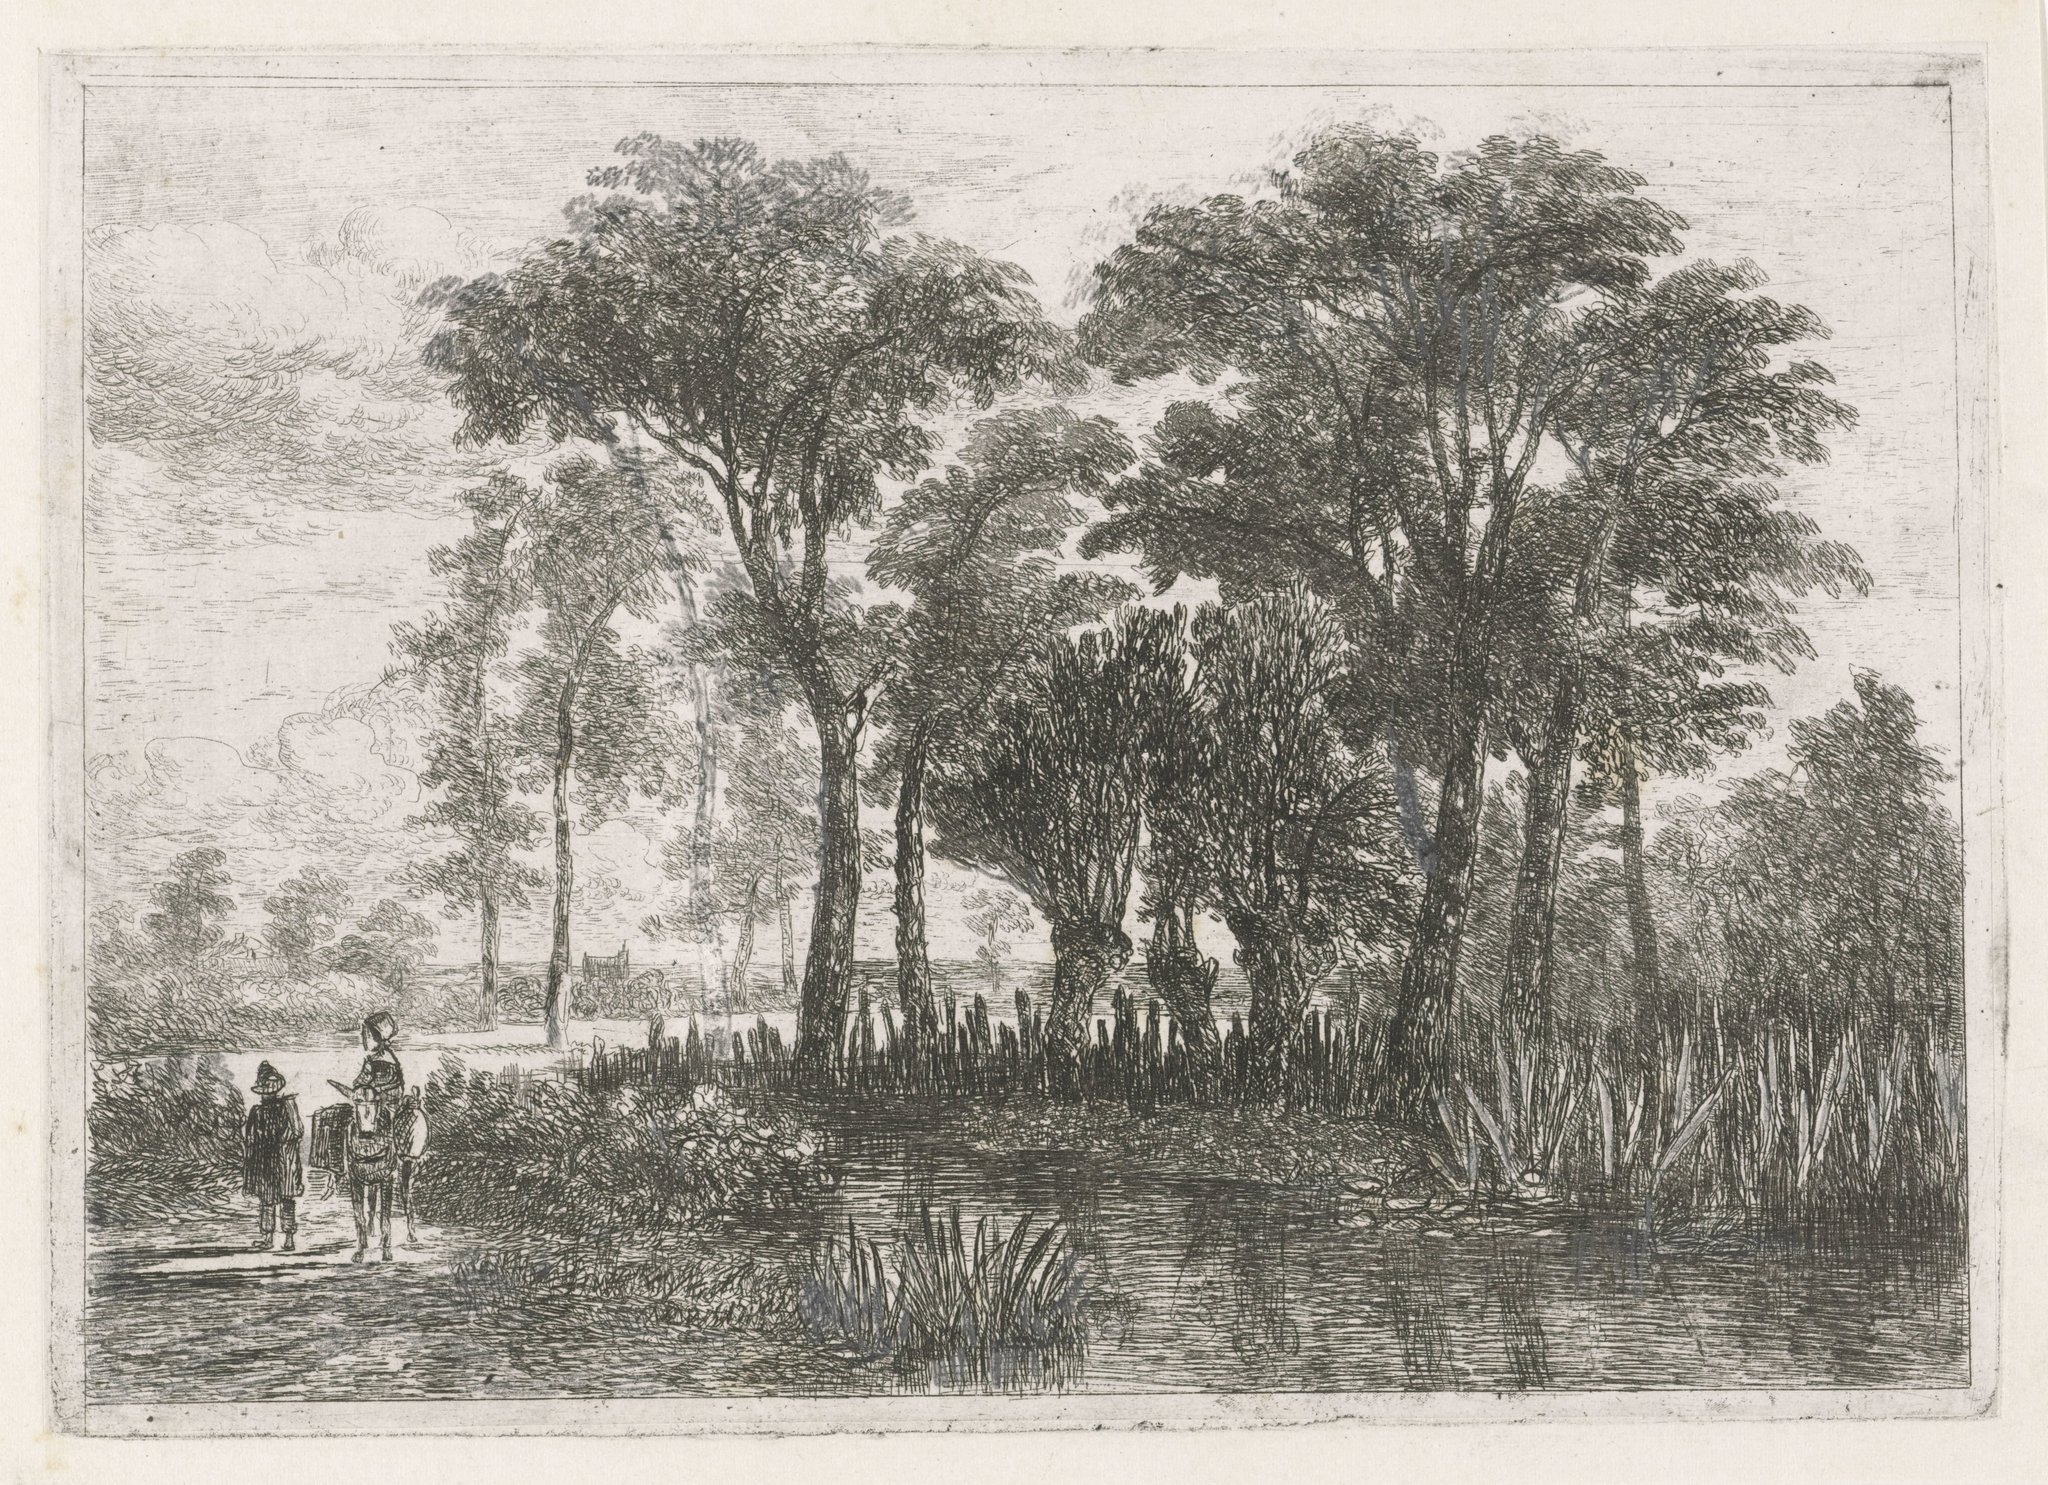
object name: print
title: Boslandschap met een vrouw op een ezel en een wandelaar bij een ven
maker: hermanus jan hendrik van rijkelijkhuysen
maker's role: painter, print maker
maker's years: 1813-1883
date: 1823-1883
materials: paper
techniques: drypoint, etching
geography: utrecht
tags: trees, fen, du. 'ven', donkey-riding (on the beach)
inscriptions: collector's mark: Lugt 2228